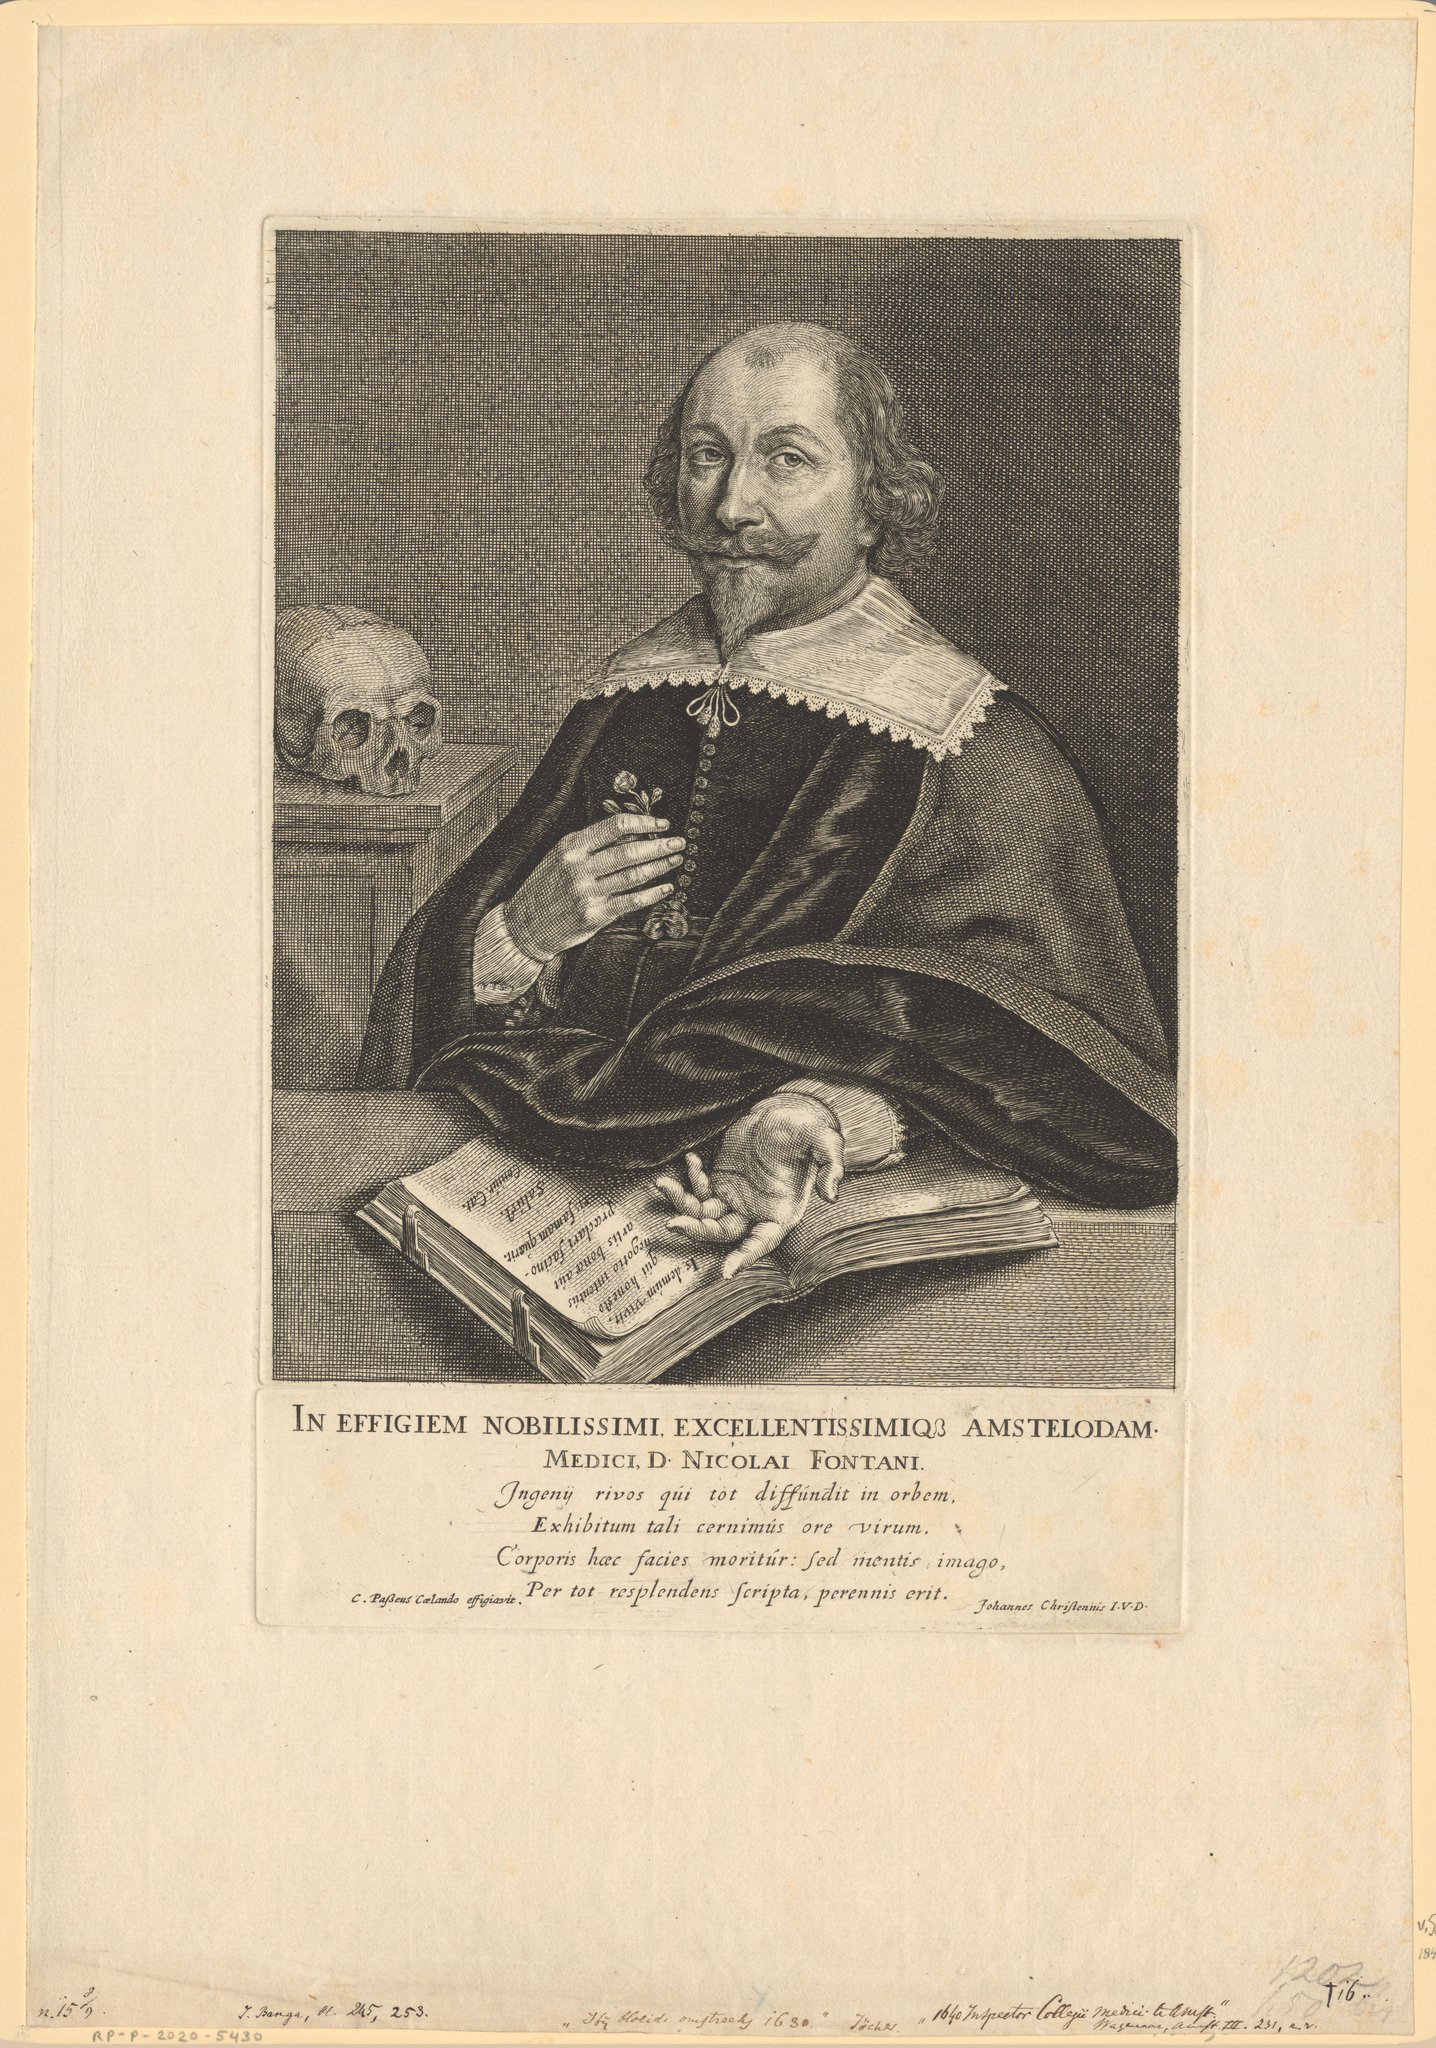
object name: print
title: Portret van Nicolaas Fonteyn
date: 1630-1670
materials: paper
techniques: engraving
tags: (human) skull, historical persons, book - mm - book open, physician, doctor (+ portrait of scholar, scientist)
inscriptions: inscription: ‘(...) "Hij bloeide omstreeks 1630" Jöcher. "1640 Inspector Collegii Medici te Amst." (...)’, collector's mark: Lugt 2228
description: Met vierregelig vers in het Latijn onder het portret, gedrukt van een aparte plaat.